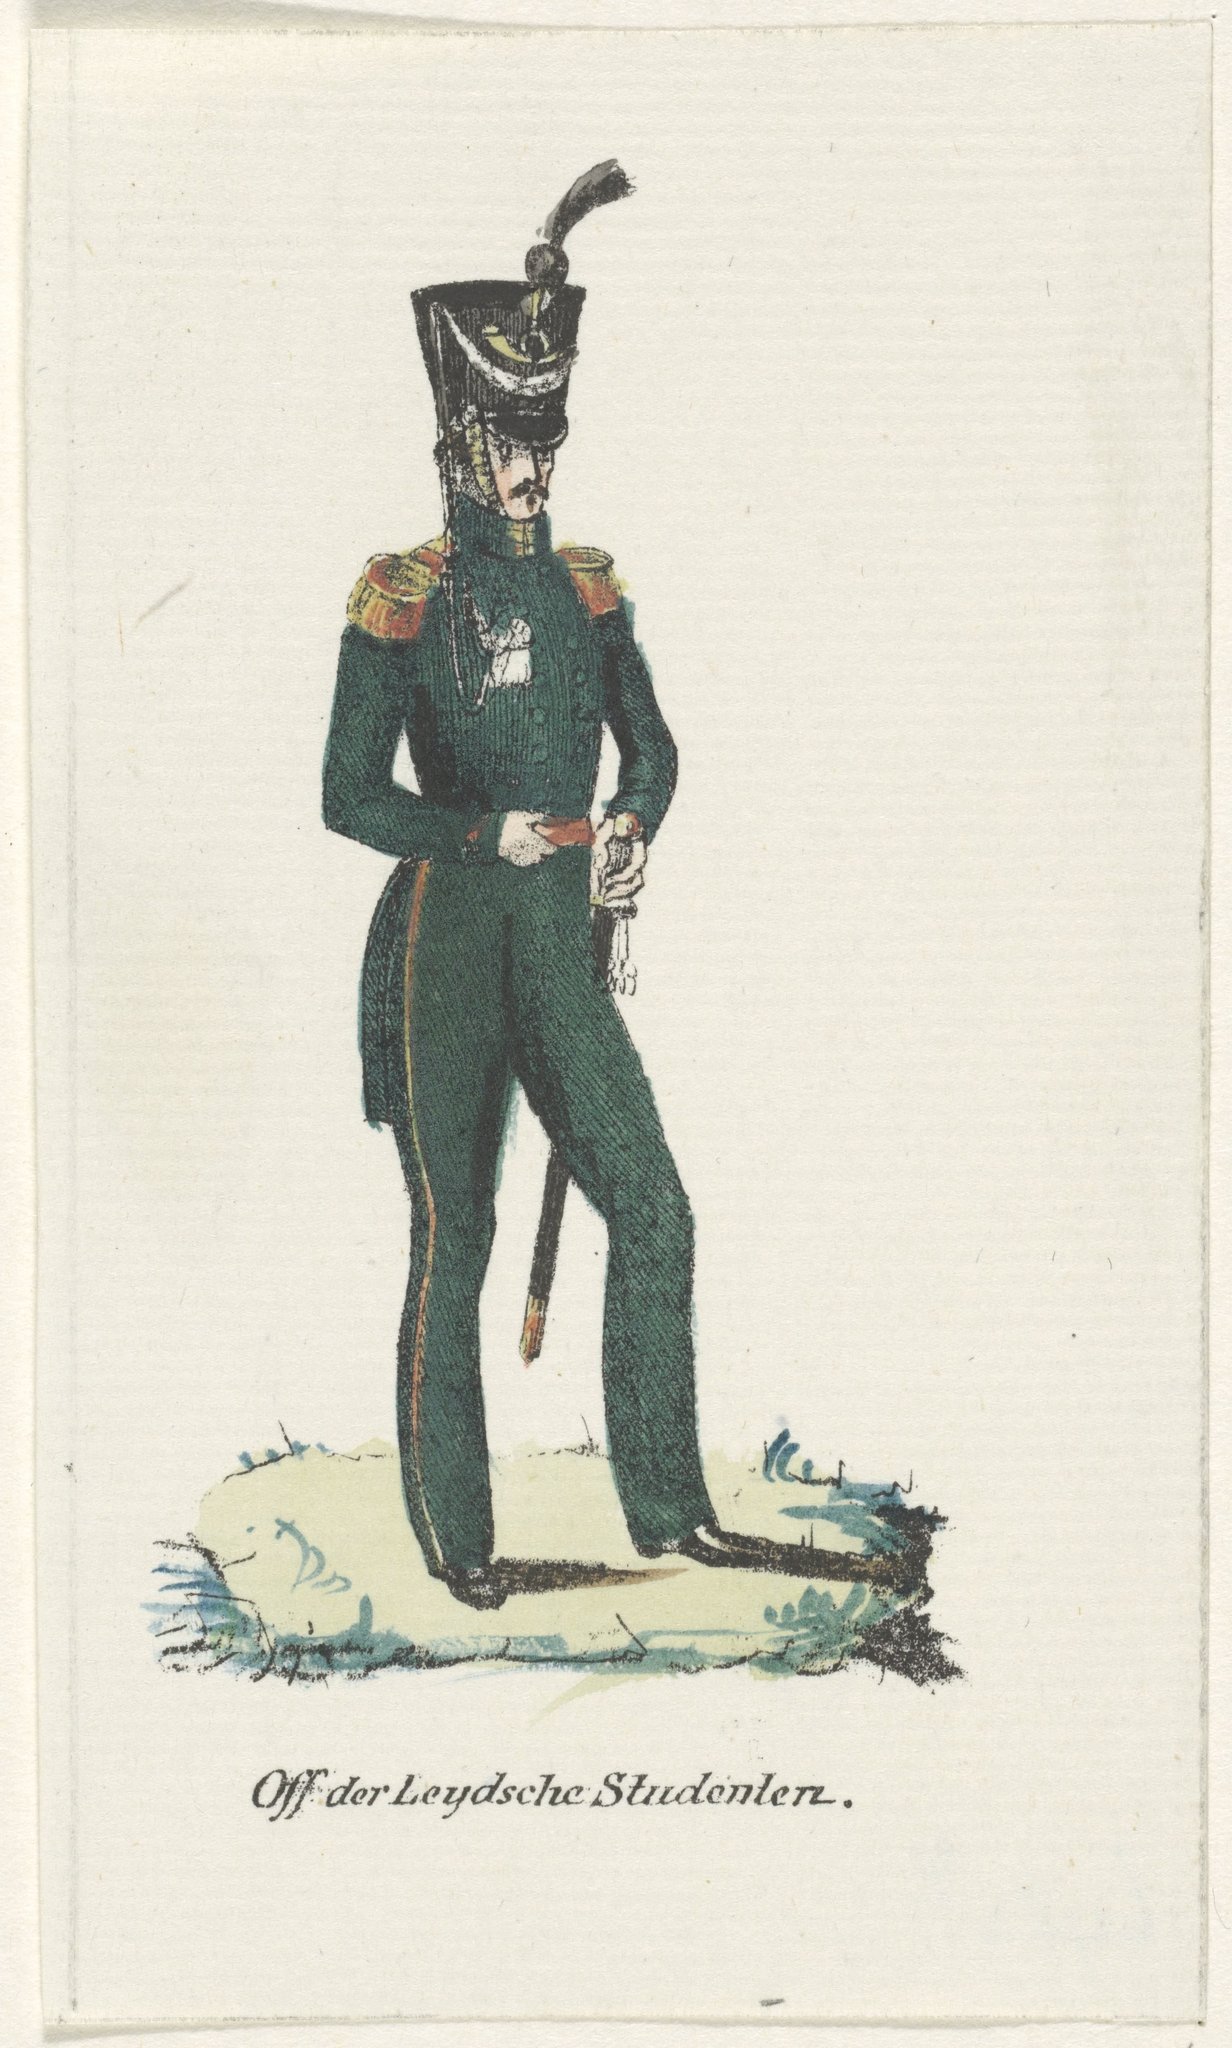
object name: costume print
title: 21 platen van Nederlandse uniformen ca. 1830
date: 1830-1835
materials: paper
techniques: hand coloring, lithograph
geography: amsterdam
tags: (military) uniforms, clothes, costume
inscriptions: collector's mark: Lugt 2228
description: Uniform van een officier van de compagnie Vrijwillige Jagers der Leidse Hogeschool. Onderdeel van een serie van 21 kleine prenten van uniformen van het Nederlandse leger (Koninklijke Nederlandsche Armée) ca. 1830.